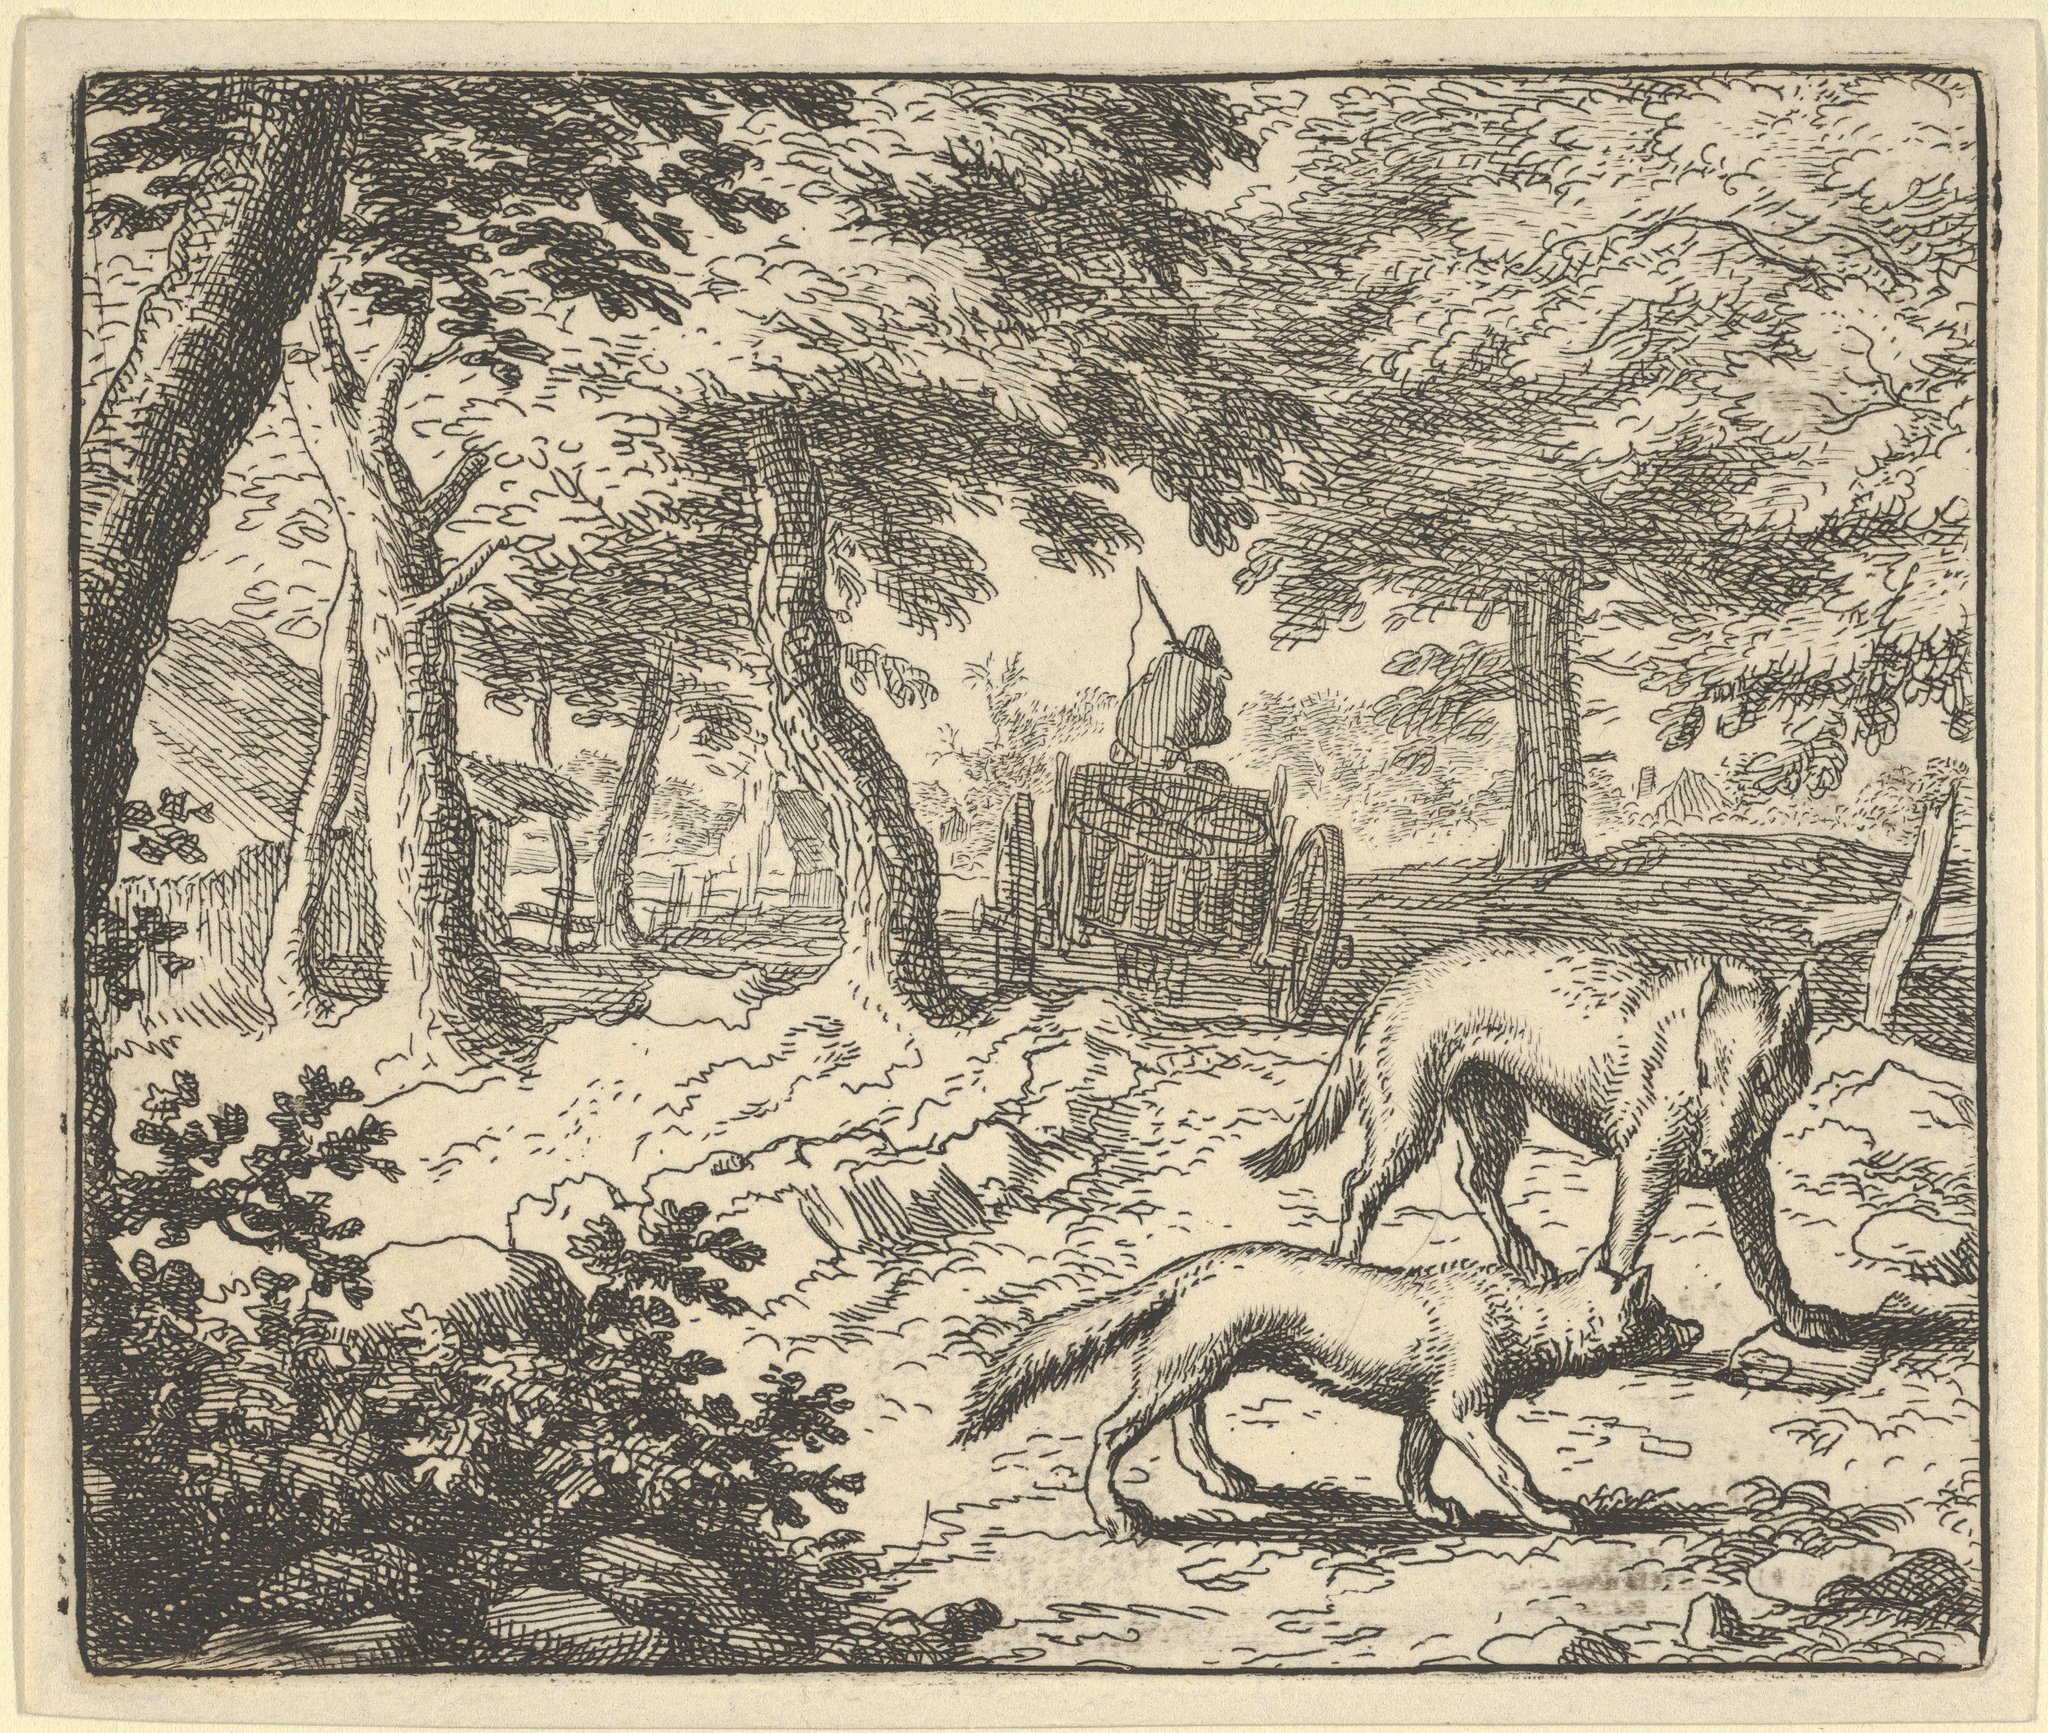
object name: print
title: The Wolf Accuses Renard of Eating the Fish that He Stole from Hendrick van Alcmar's Renard The Fox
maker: allart van everdingen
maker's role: artist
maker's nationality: dutch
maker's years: 1621-1675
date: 1650-1675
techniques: engraving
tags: animals,forests,carriages